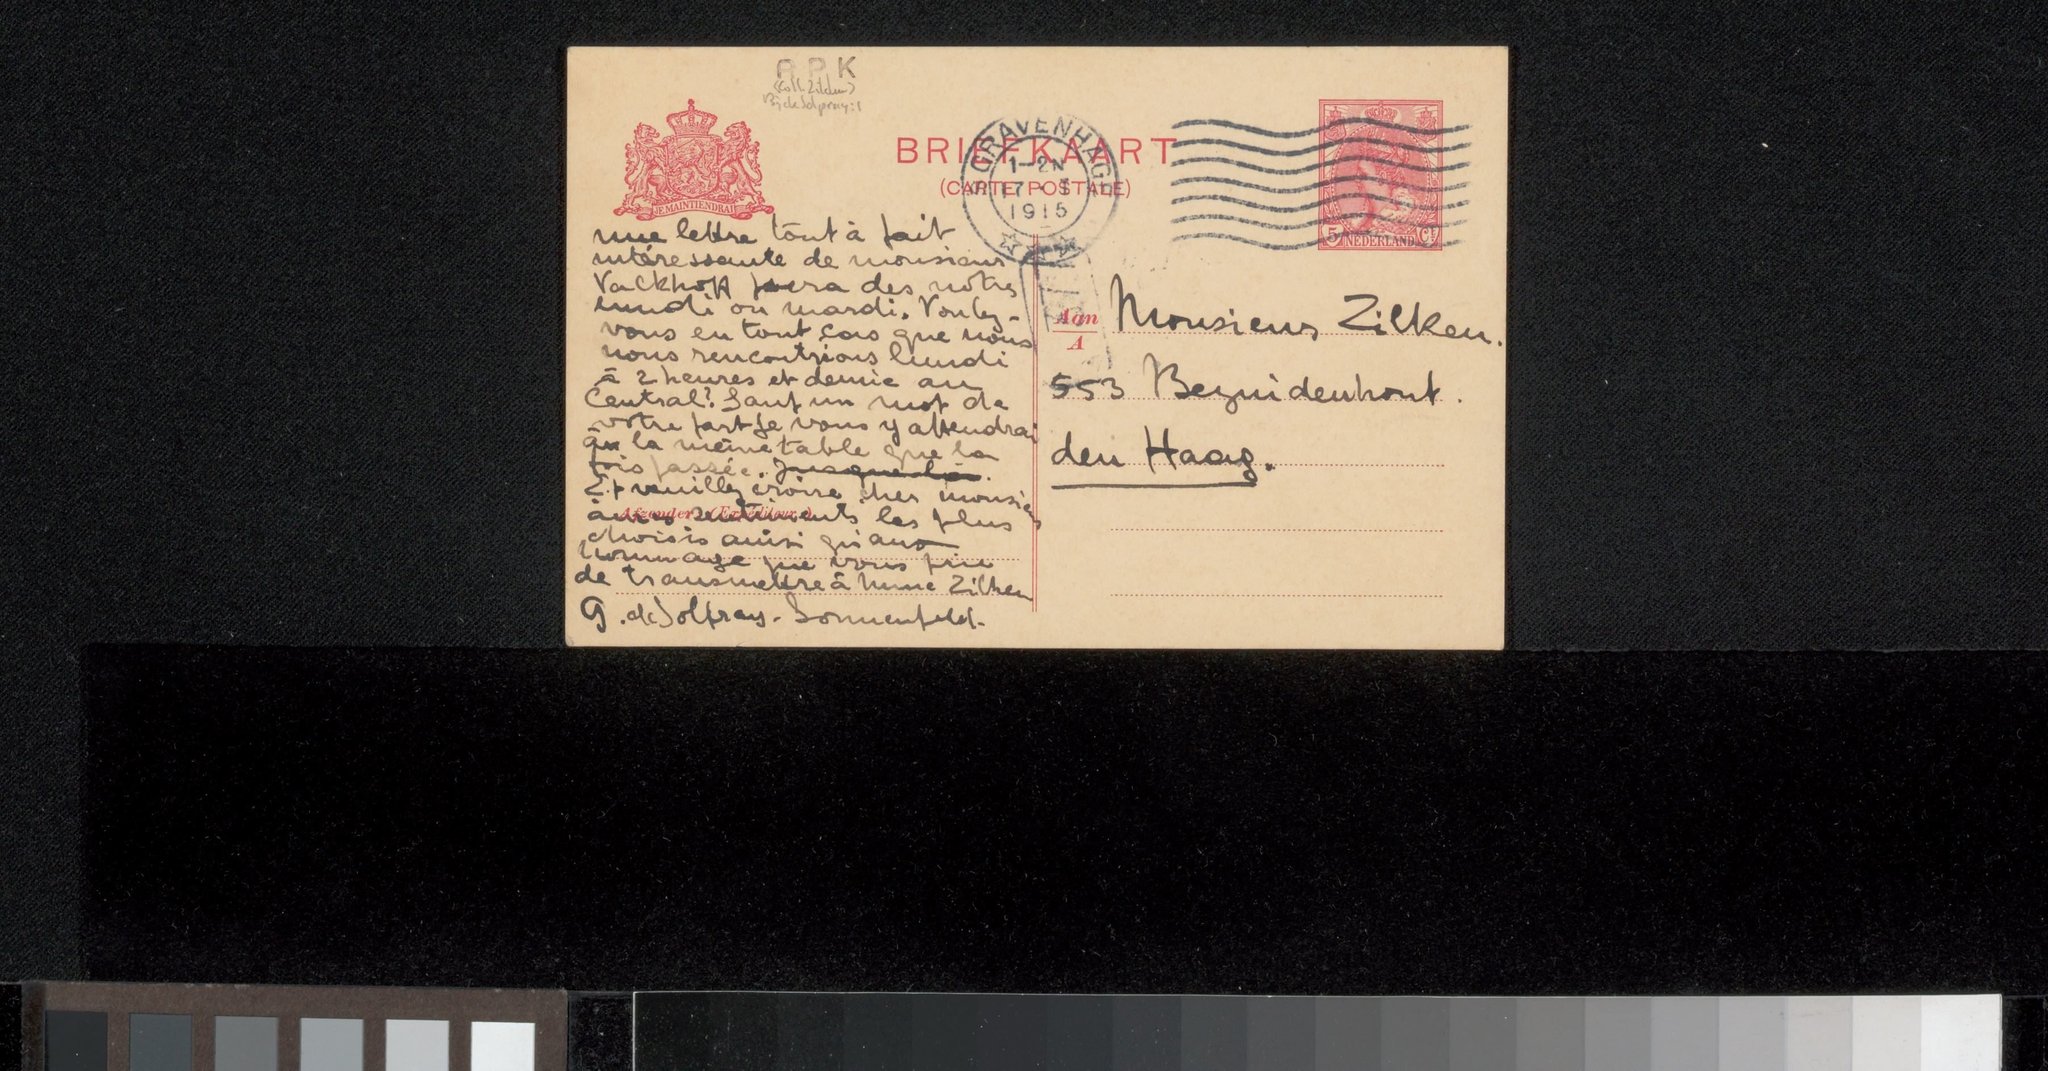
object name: postcard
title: Briefkaart aan Philip Zilcken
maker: georges de solpray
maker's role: schrijver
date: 1915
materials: cardboard, ink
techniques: pen, writing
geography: the hague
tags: paris, louis piérard, the hague, painter, draughtsman, philip zilcken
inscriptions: collector's mark: ‘RPK’